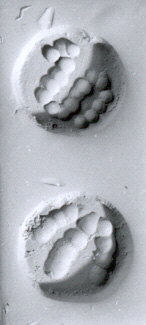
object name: stamp seal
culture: bactria-margiana archaeological complex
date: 2333-1668 BCE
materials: lapis lazuli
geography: bactria-margiana